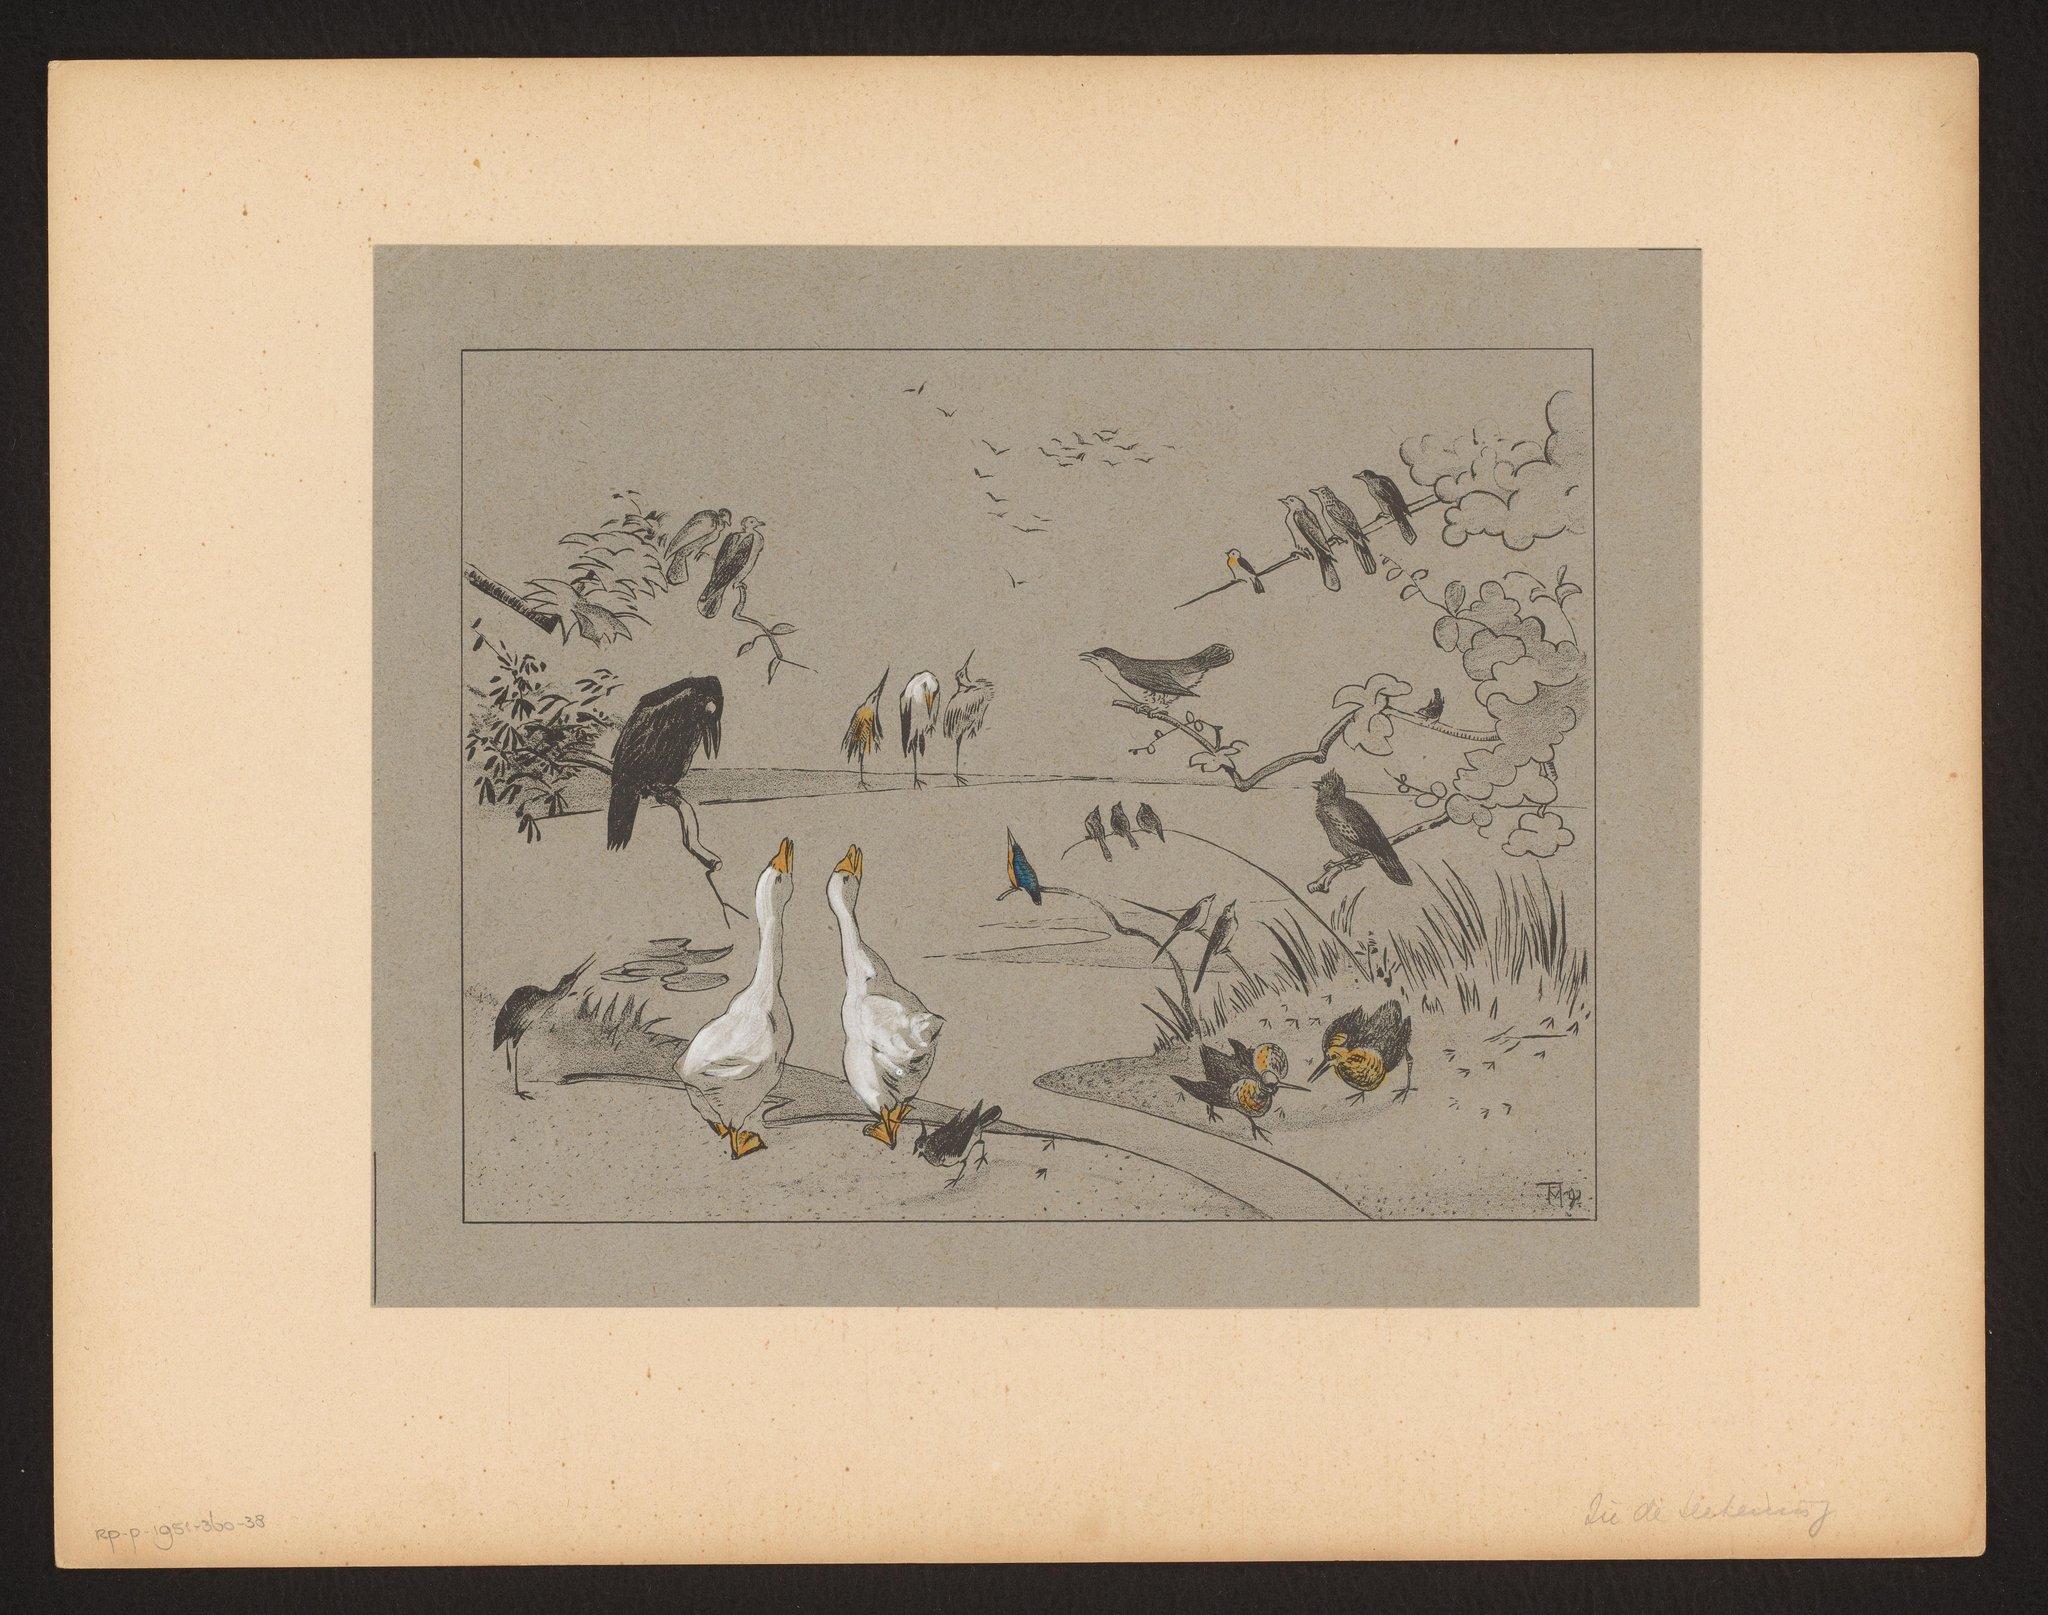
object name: print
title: Hoe de vogels aan een koning kwamen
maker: theo van hoytema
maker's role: draughtsman, painter, print maker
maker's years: 1863-1917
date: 1892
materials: paper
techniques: hand coloring, lithograph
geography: the hague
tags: water-birds: goose, shore-birds and wading-birds: stork, song-birds: crow, song-birds: wren, shore-birds and wading-birds: lapwing, other birds: kingfisher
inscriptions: annotation: ‘Zie de teekening’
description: Onder andere een kraai, twee ganzen, een ijsvogel, kievit, twee kemphanen, een koekoek en een winterkoninkje.